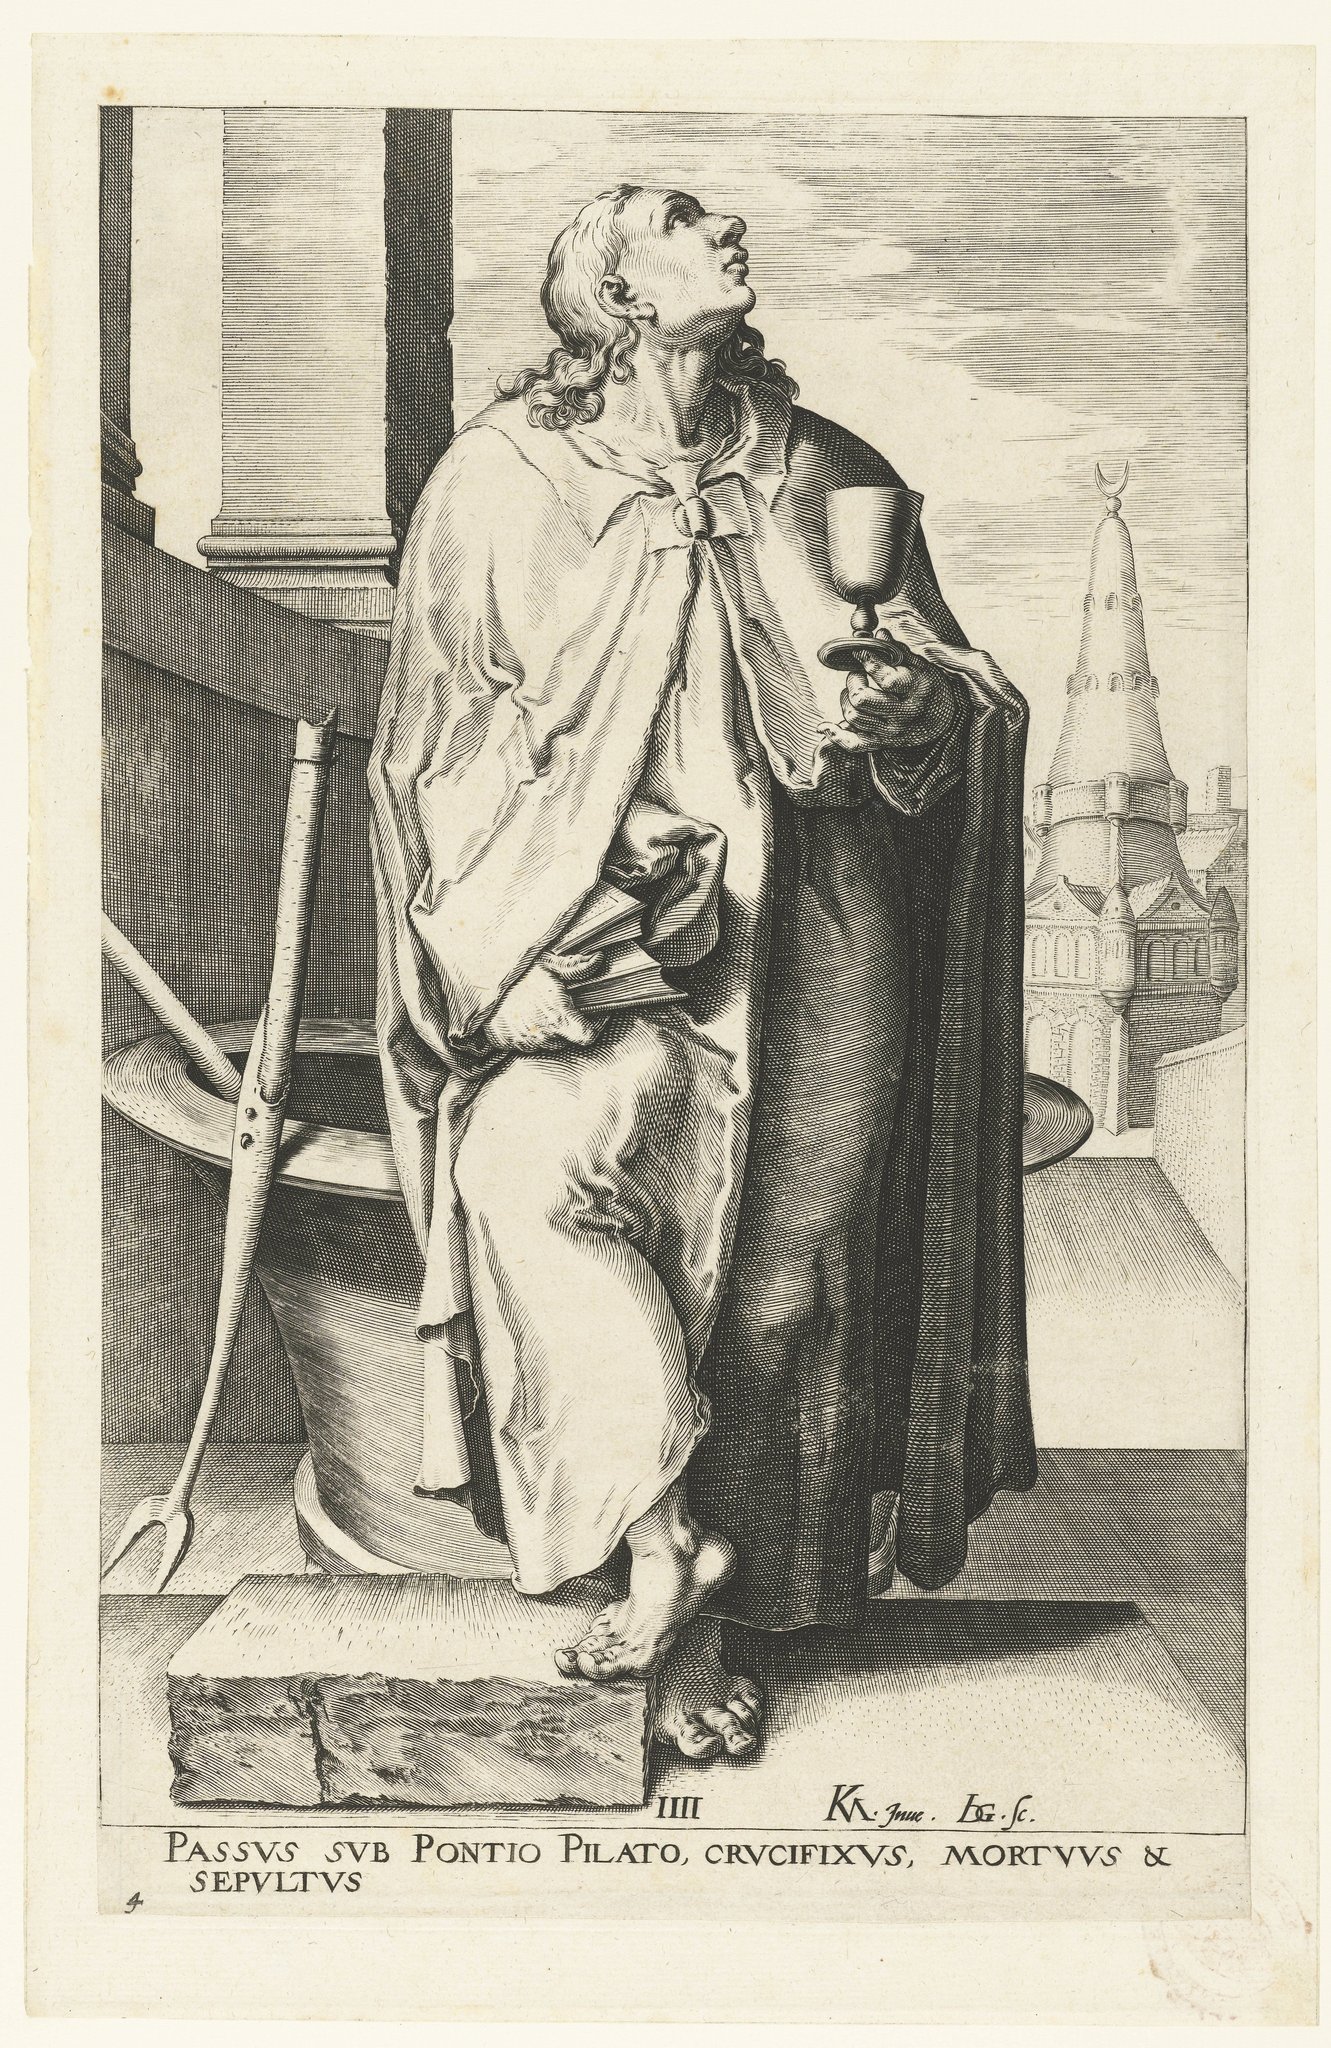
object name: print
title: Apostel Johannes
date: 1591-1592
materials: paper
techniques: engraving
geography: amsterdam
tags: the apostle john the evangelist; possible attributes: book, cauldron, chalice with snake, eagle, palm, scroll, 'passus sub pontio pilato, crucifixus, mortuus et sepultus est' ~ articles of faith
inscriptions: collector's mark: Lugt 240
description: De apostel Johannes, staand in een architectonische omgeving, geleund tegen een grote kookpot, in de rechterhand een boek, in de linkerhand een beker. Zijn linkervoet steunt op een blok steen. Onder de voorstelling twee regels Latijnse tekst. Deze prent is onderdeel van een serie van 14 prenten, elk bestaand uit een beeltenis ten voeten uit van een apostel, Christus of Paulus met typerende attributen en een onderschrift in Latijn.